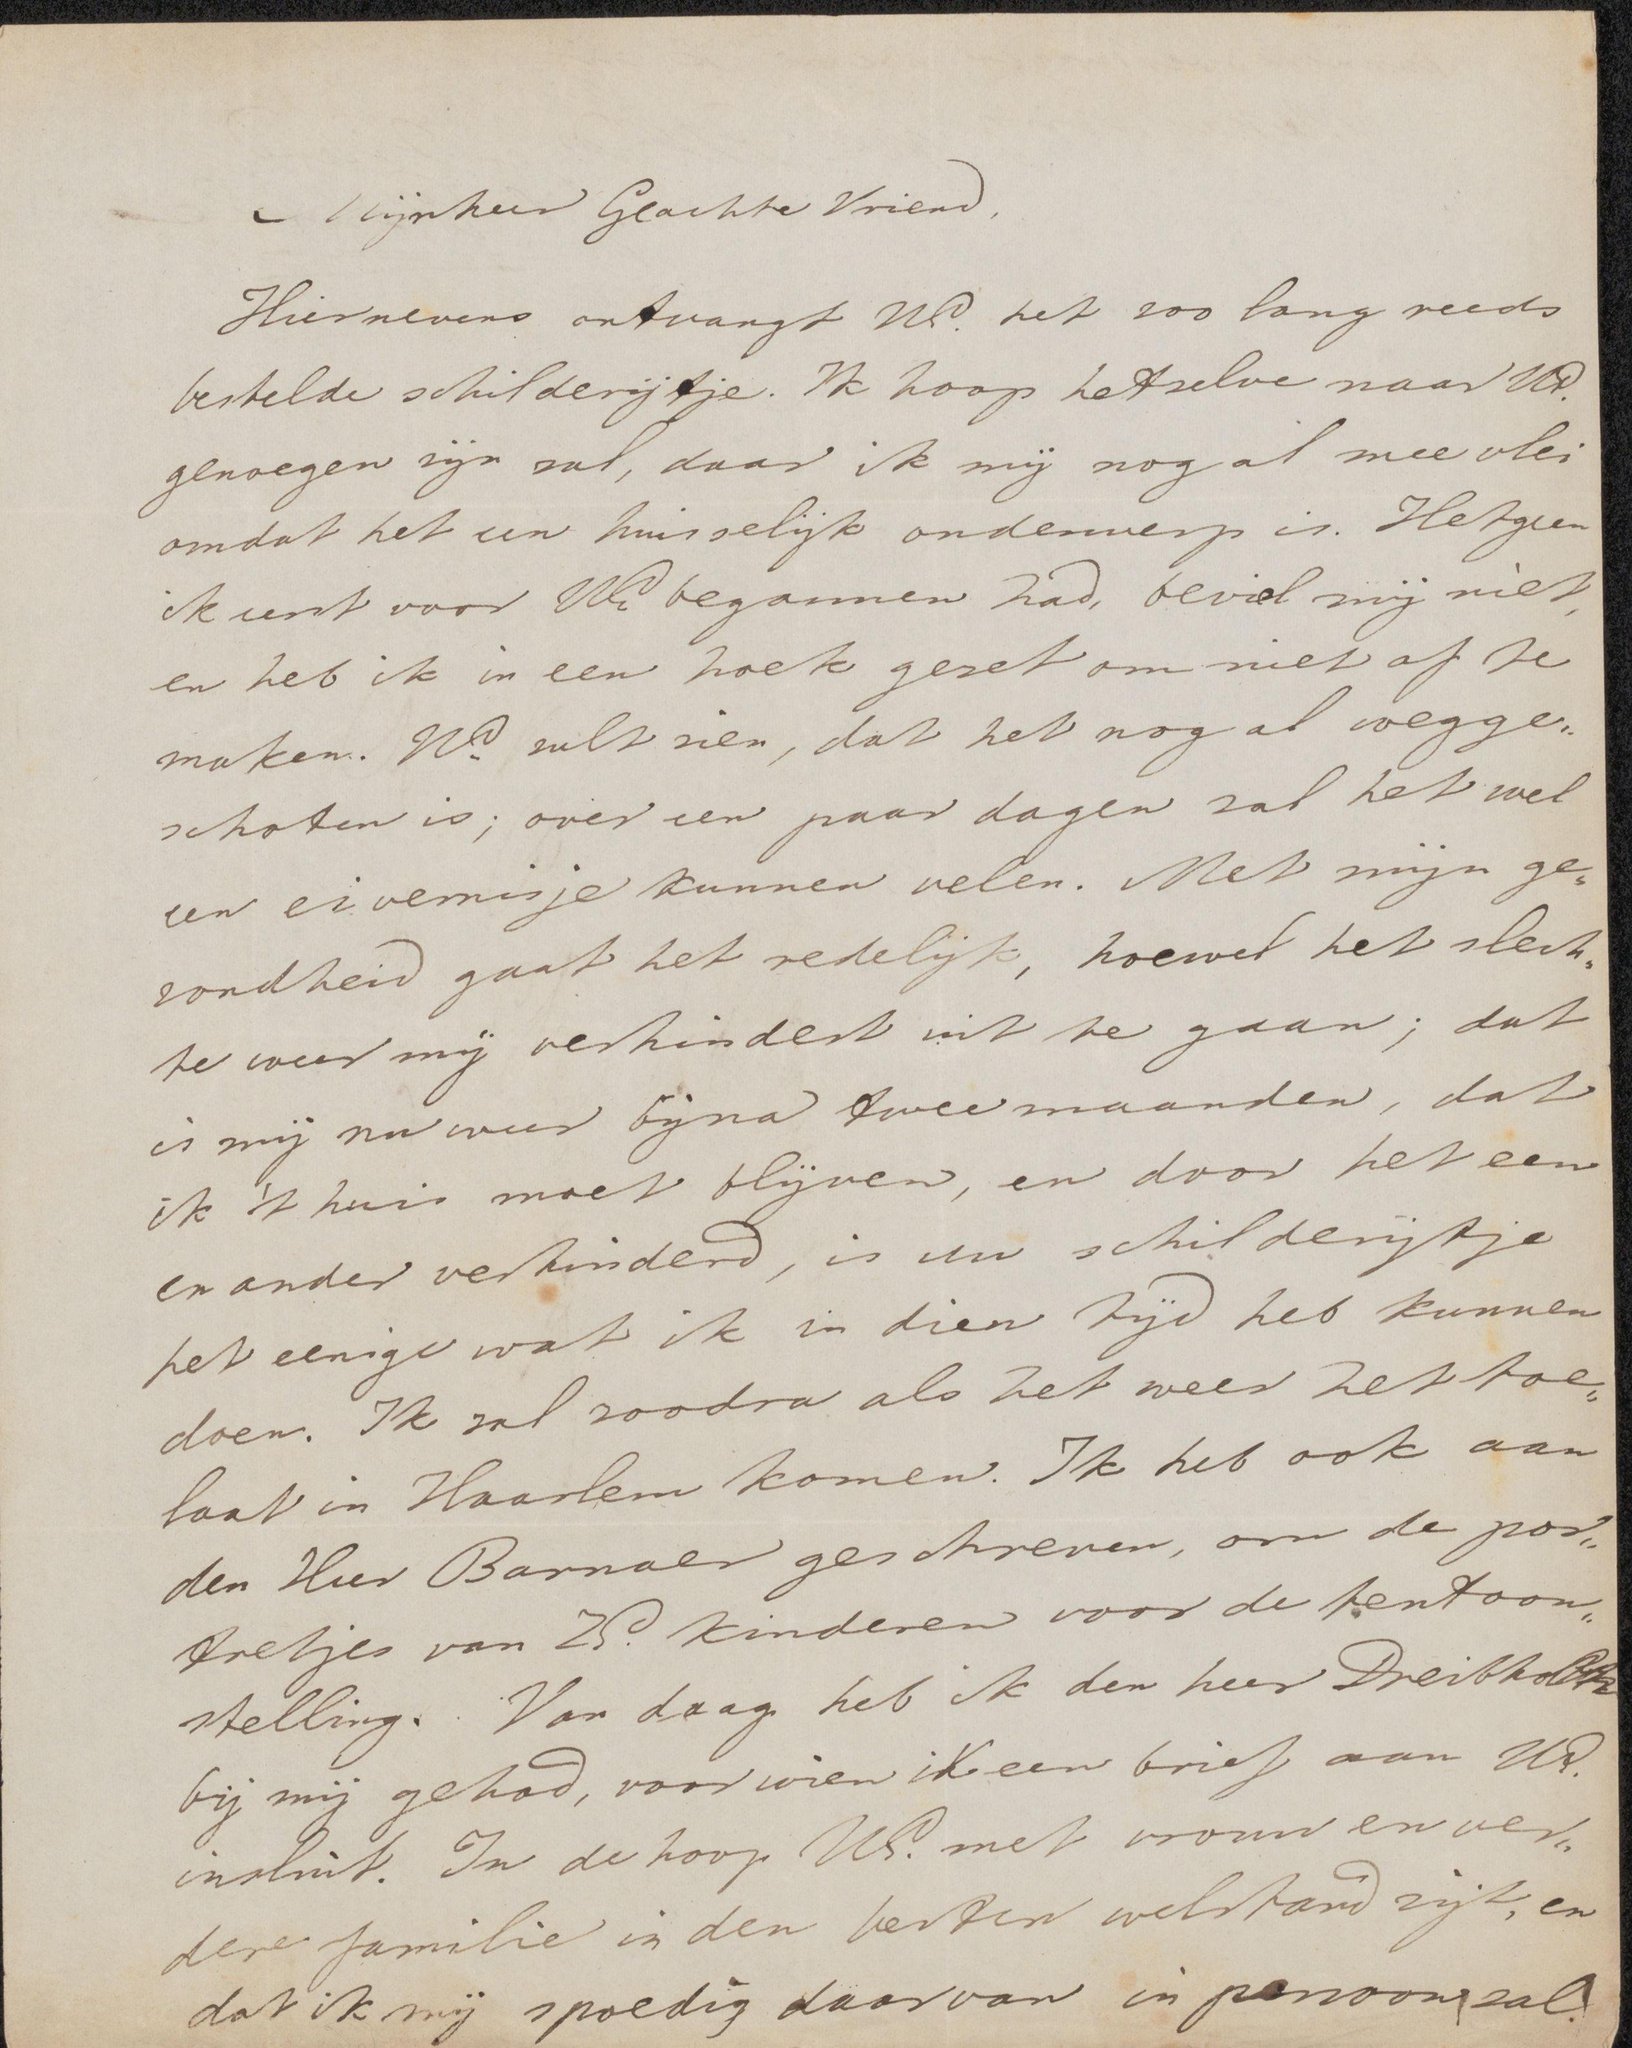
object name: letter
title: Brief aan B. Verpoorten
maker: adrianus johannes ehnle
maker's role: draughtsman, print maker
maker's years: 1819-1863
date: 1829-1863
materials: ink, paper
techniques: pen, writing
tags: b. verpoorten, painting (including book-illumination, miniature-painting), exhibition ~ art, diseases, historical persons (portraits and scenes from the life), haarlem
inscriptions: collector's mark: ‘RPK’